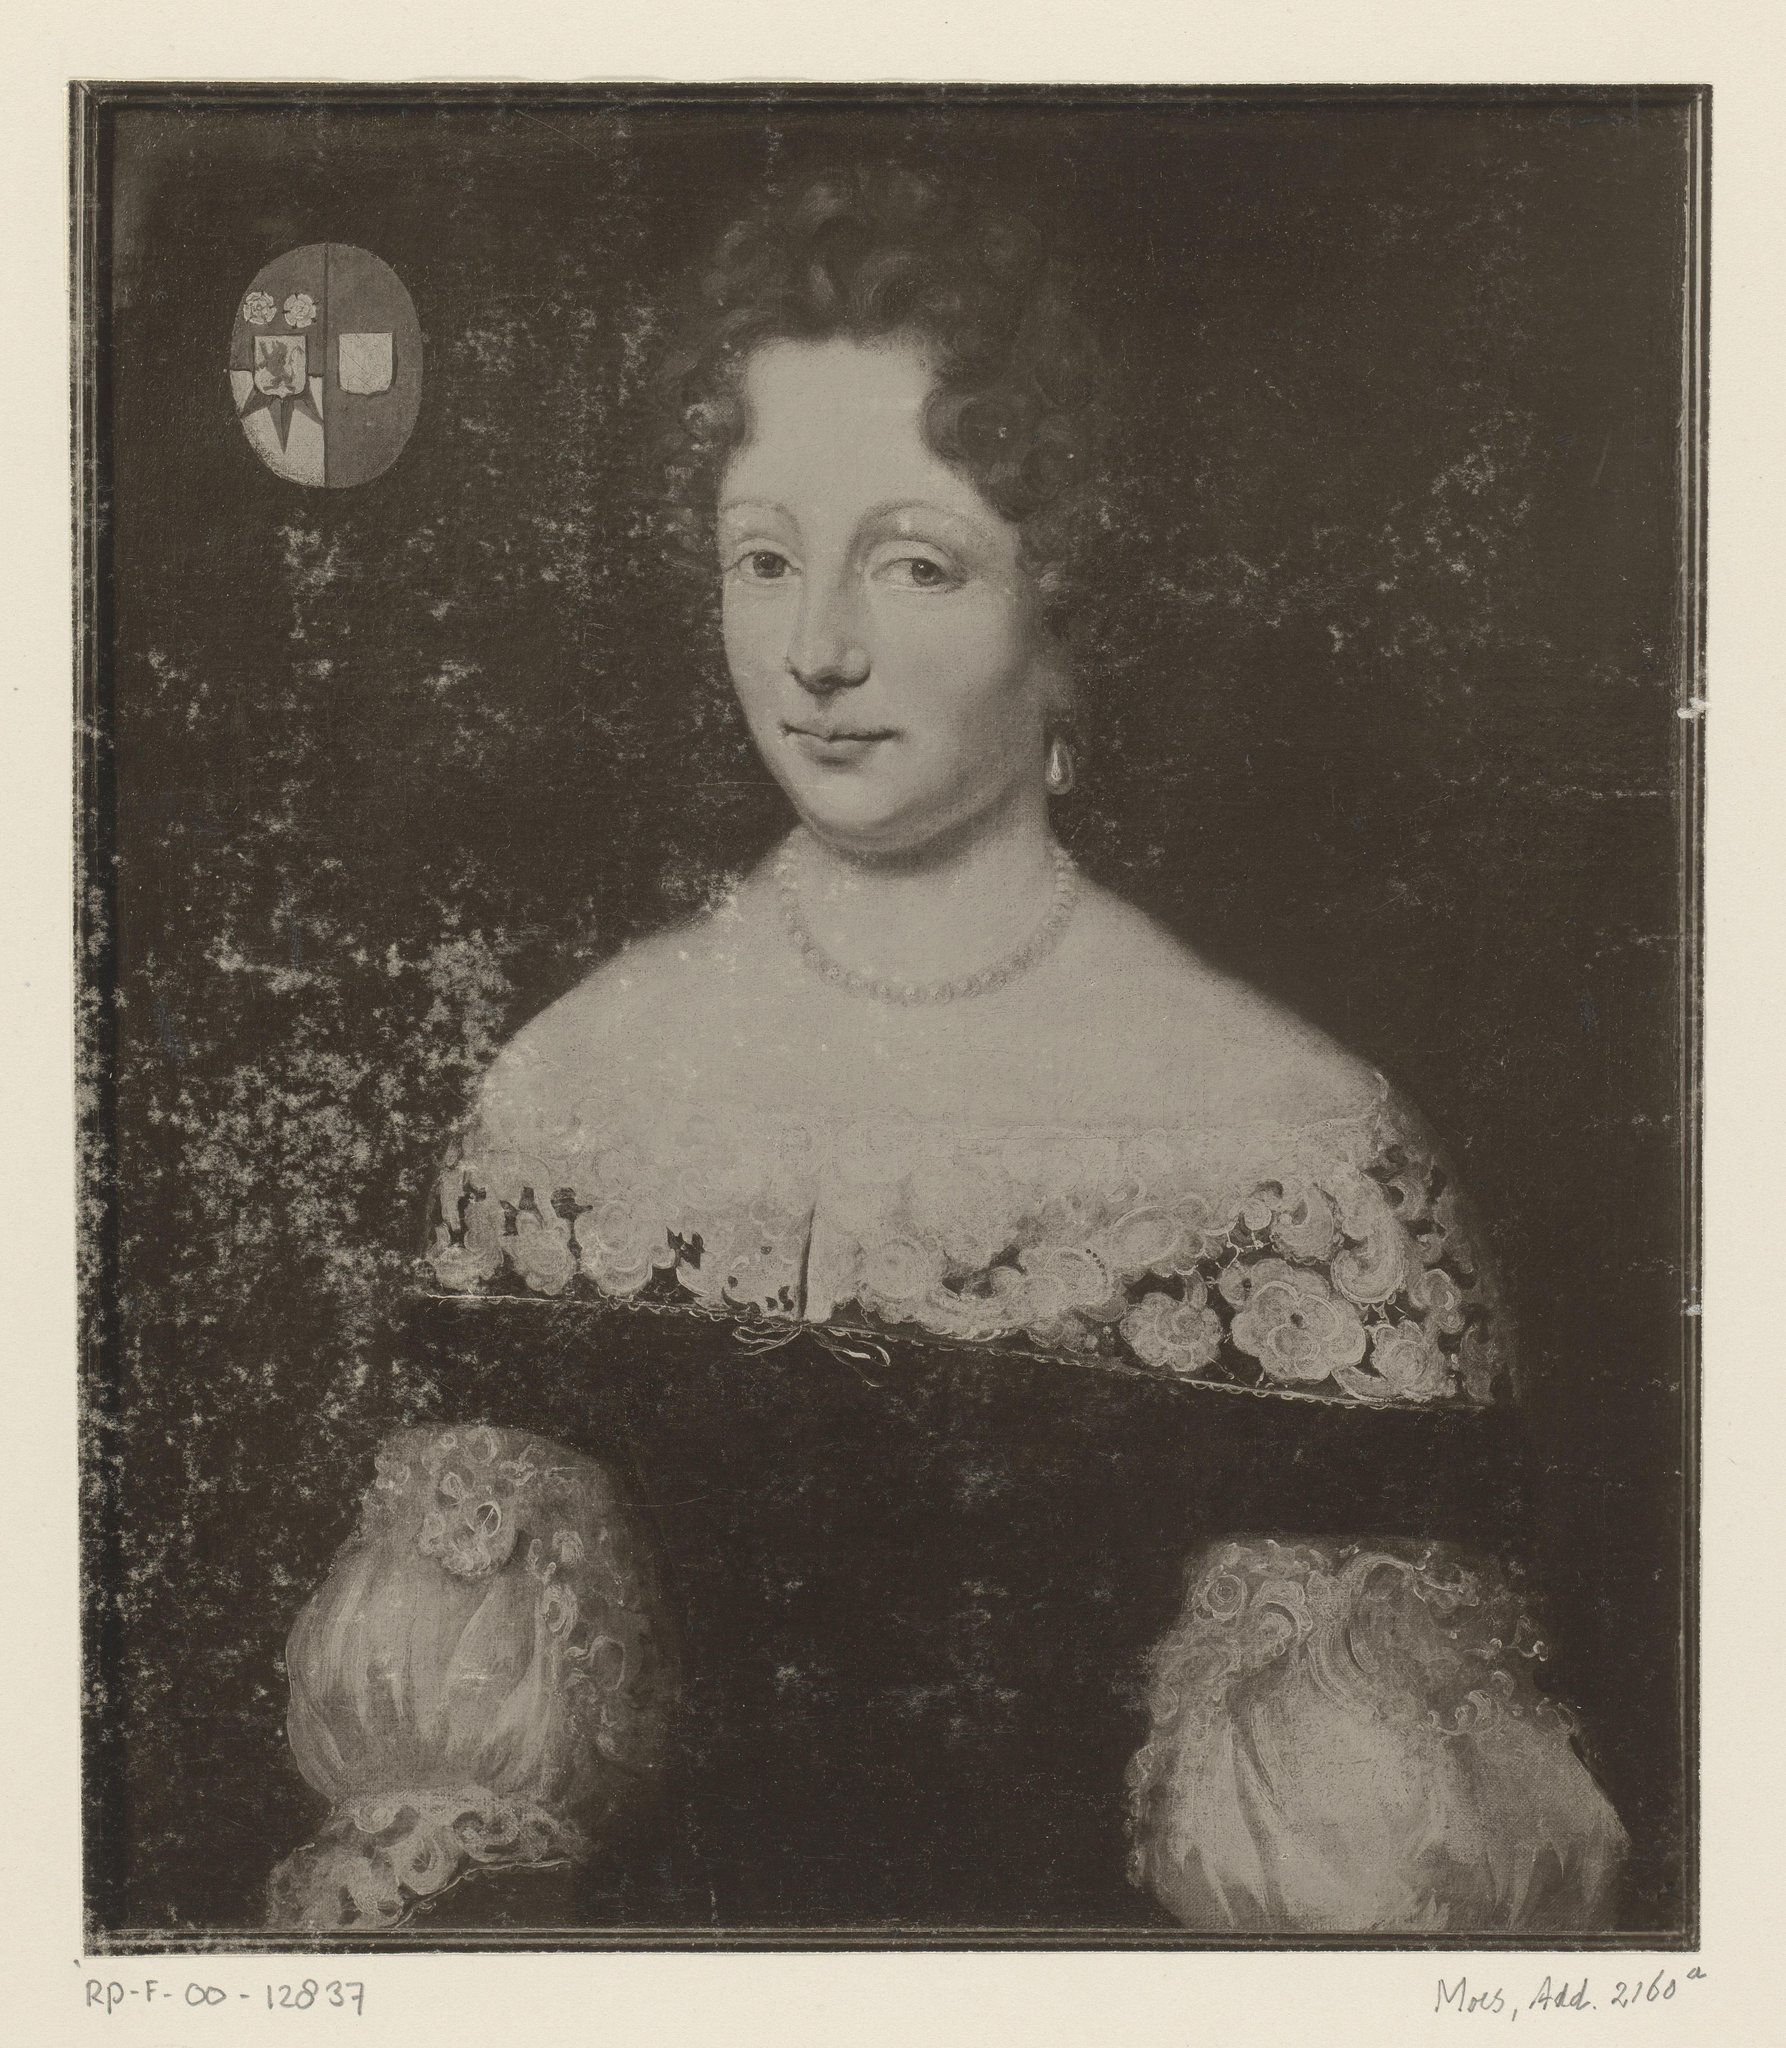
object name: reproduction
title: Fotoreproductie van een geschilderd portret van Elisabeth Droste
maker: Anonymous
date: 1904-1920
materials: paper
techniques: gelatin silver print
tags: historical persons - bb - woman, picture, painting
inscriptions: inscription: ‘Elisabeth. Droogendijck/ cat. 162 6./ onbekend.’